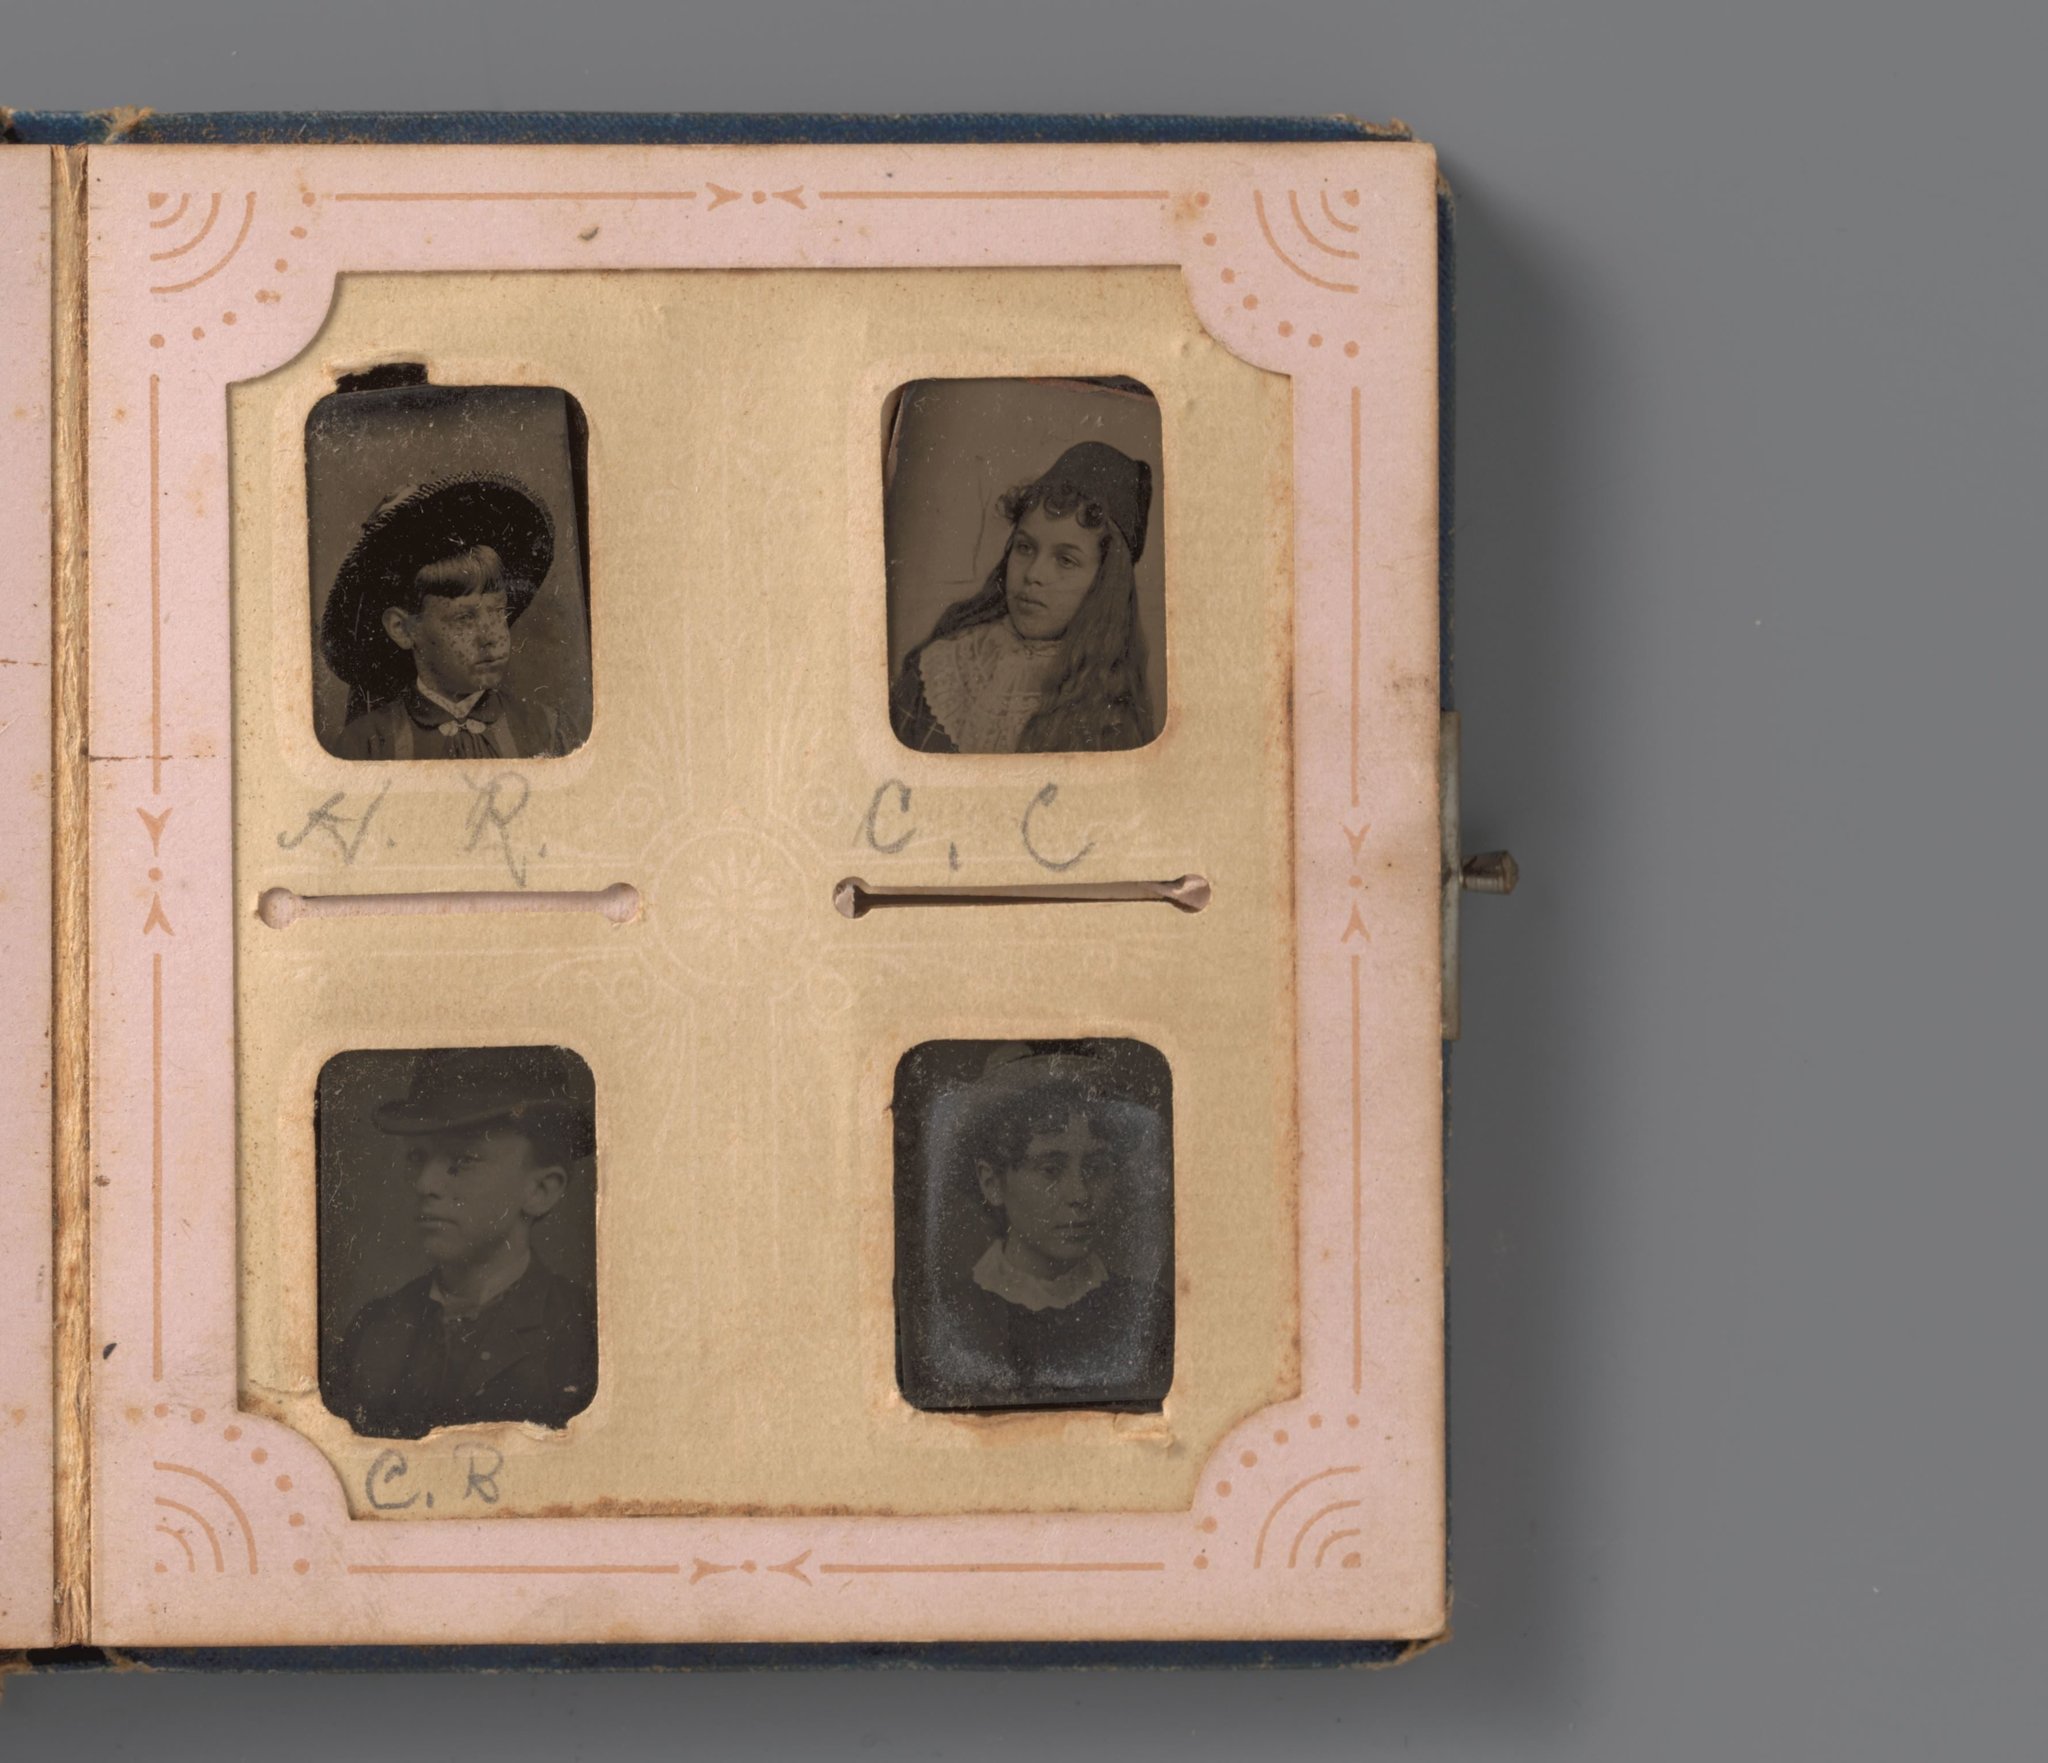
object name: album leaf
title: Vier portretten van jonge vrouwen en een jonge man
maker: Anonymous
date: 1855-1940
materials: cardboard, iron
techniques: ferrotyping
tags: adolescent, young woman, maiden, historical persons - bb - woman, historical persons, youth, adolescent, head-gear: hat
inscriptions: monogram: ‘C. R’, monogram: ‘C. C’, monogram: ‘H. R.’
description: Deze foto's maken deel uit van een album.